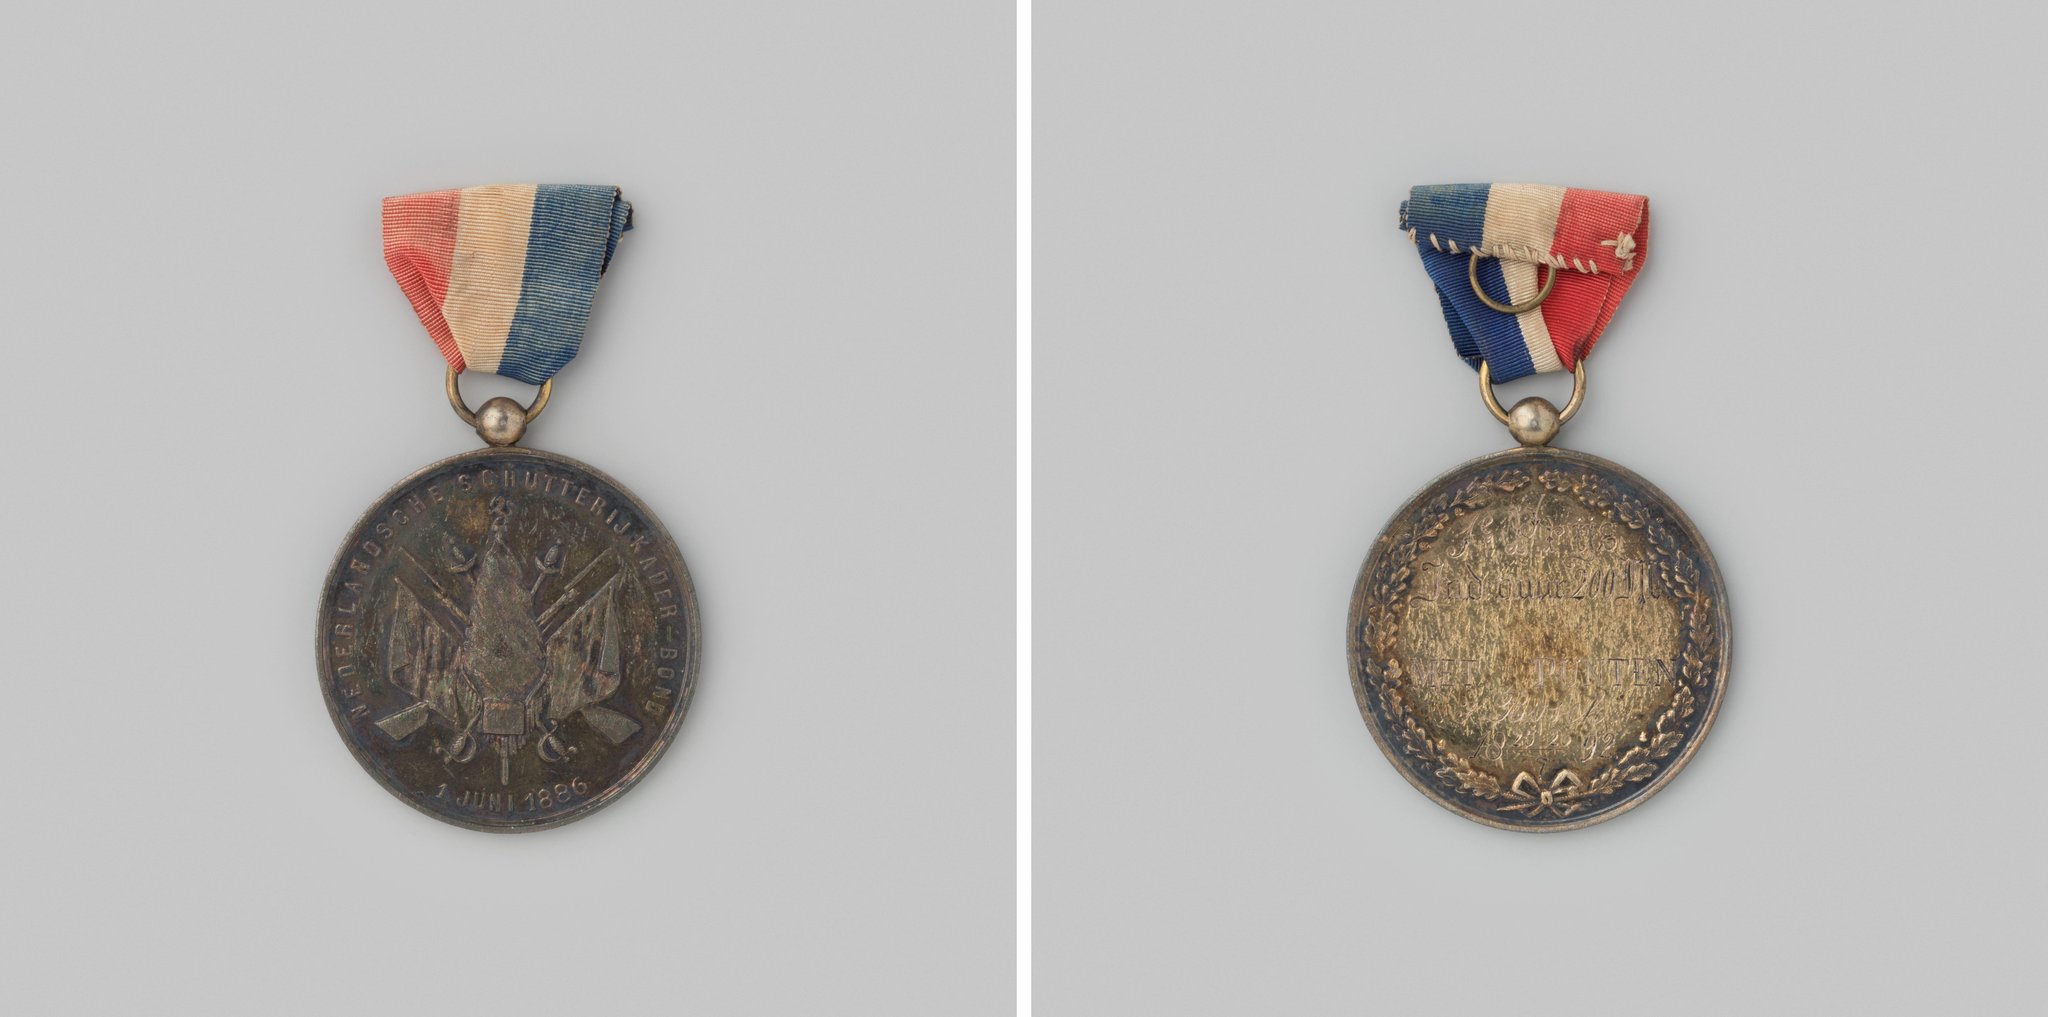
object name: draagpenning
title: Prijspenning van de Nederlandsche Schutterij Kader-Bond, 1892, individueel vuur, eerste prijs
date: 1892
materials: silver, textile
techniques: gilding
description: Verguld zilveren penning met knop, ring en lint.